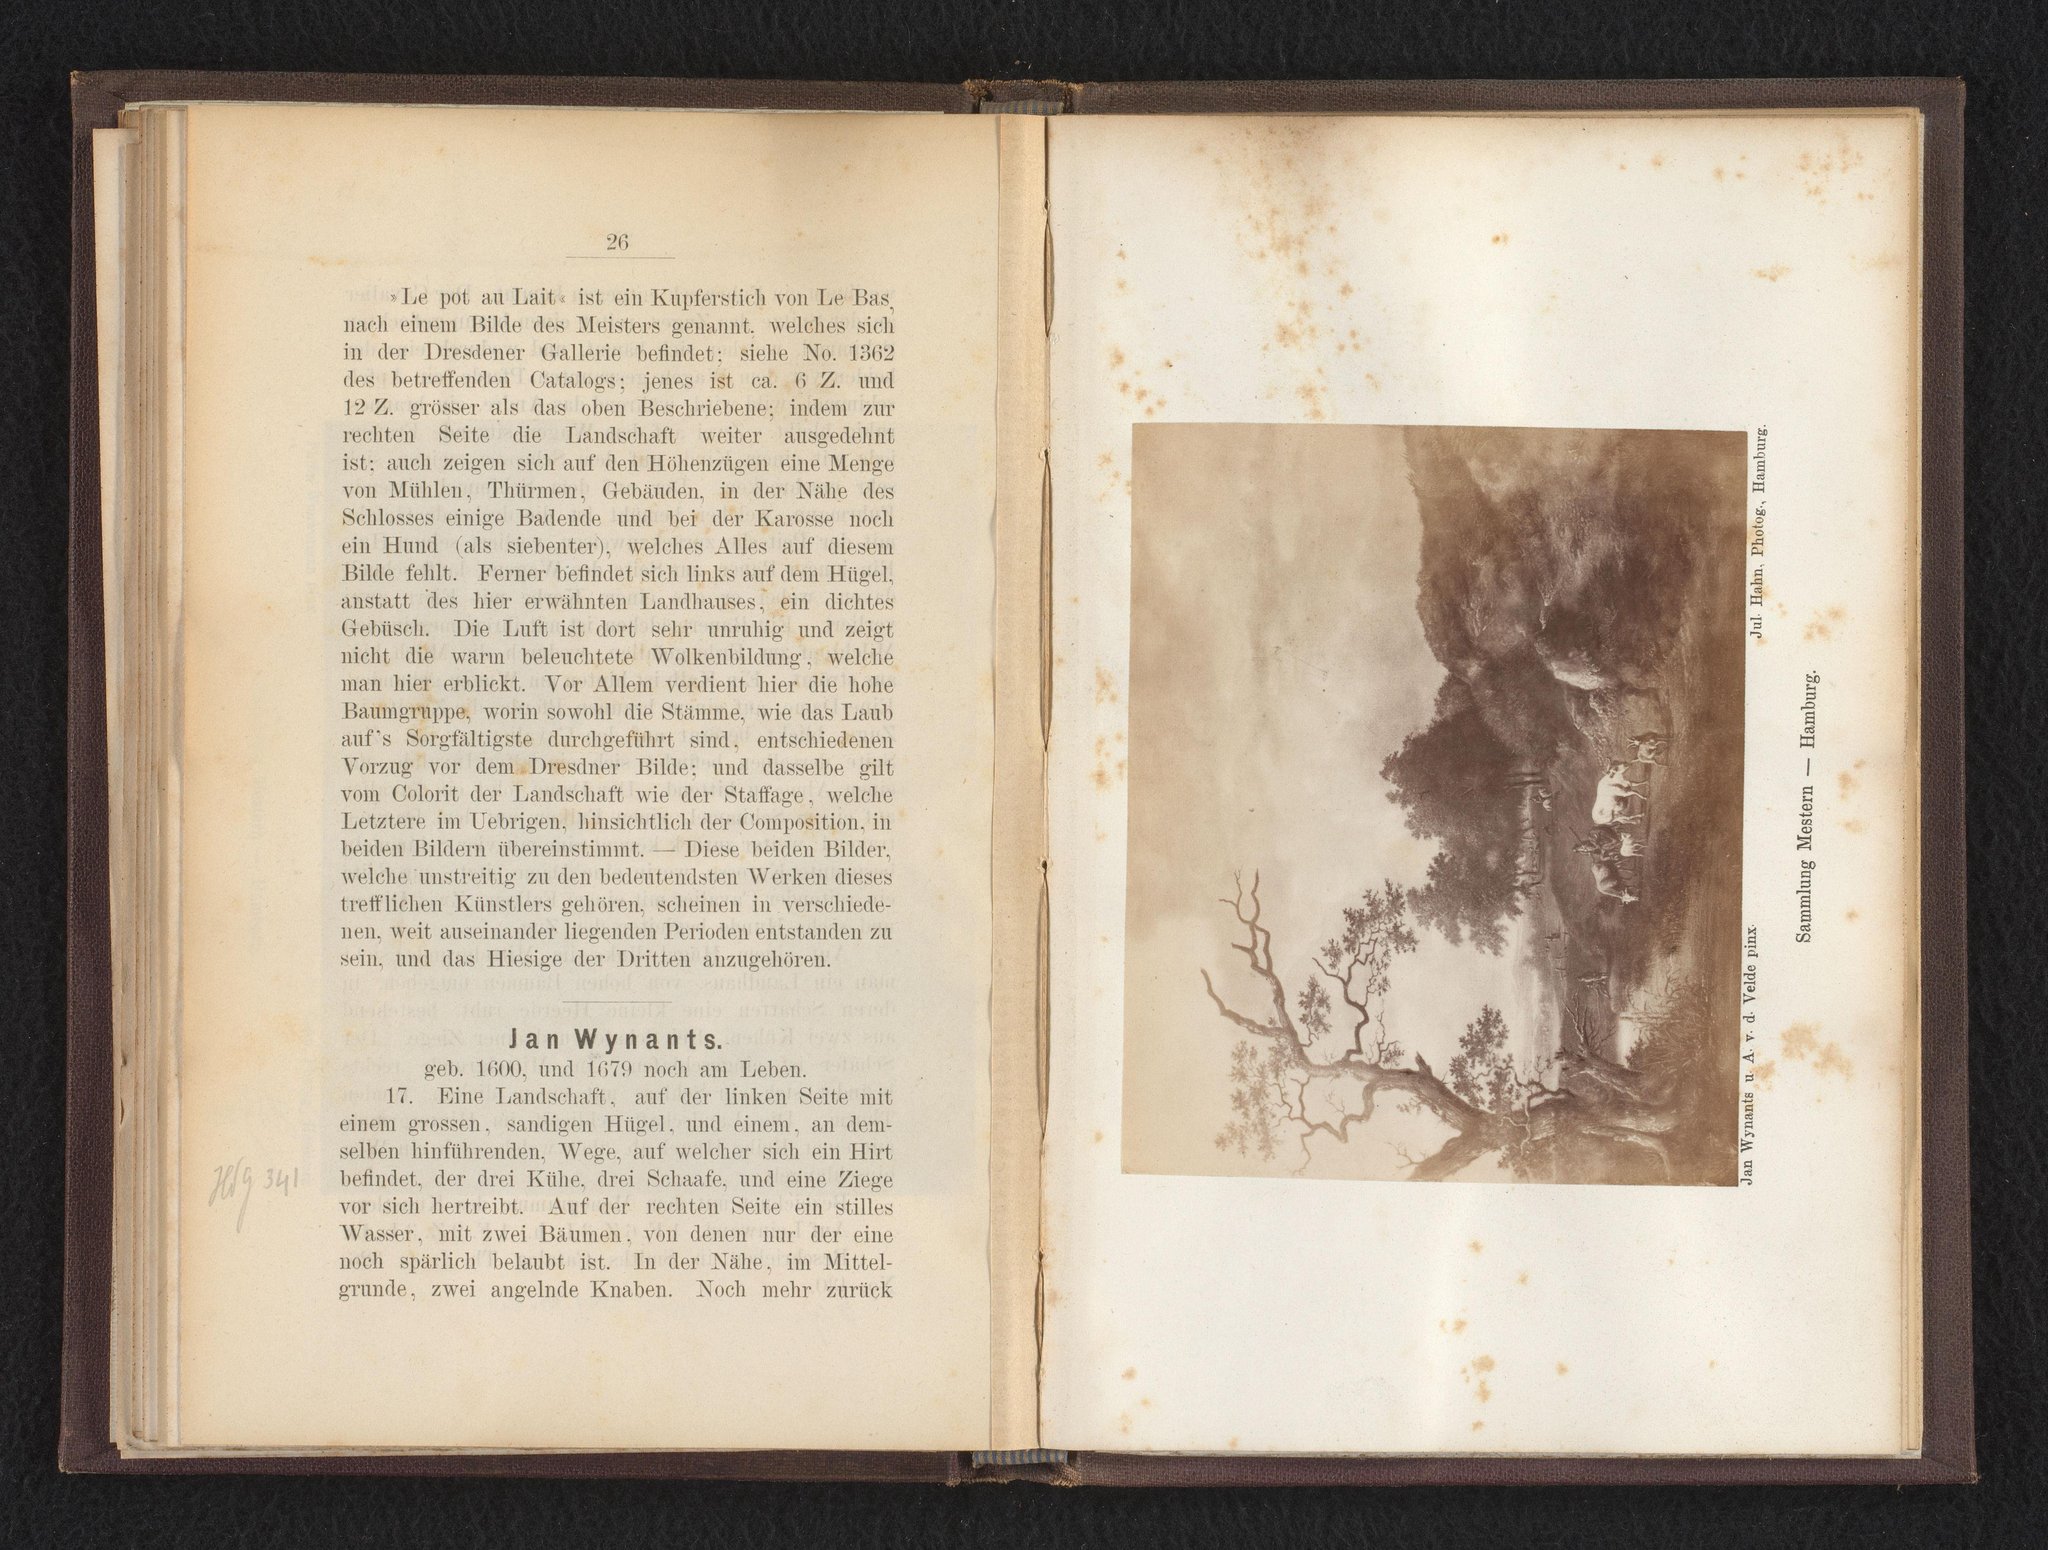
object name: reproduction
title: Fotoreproductie van een schilderij van herders en vee in een landschap door Jan Wijnants en Adriaen van de Velde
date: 1864-1874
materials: paper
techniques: albumen print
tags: picture, painting, landscapes (+ landscape with figures, staffage), herd, flock